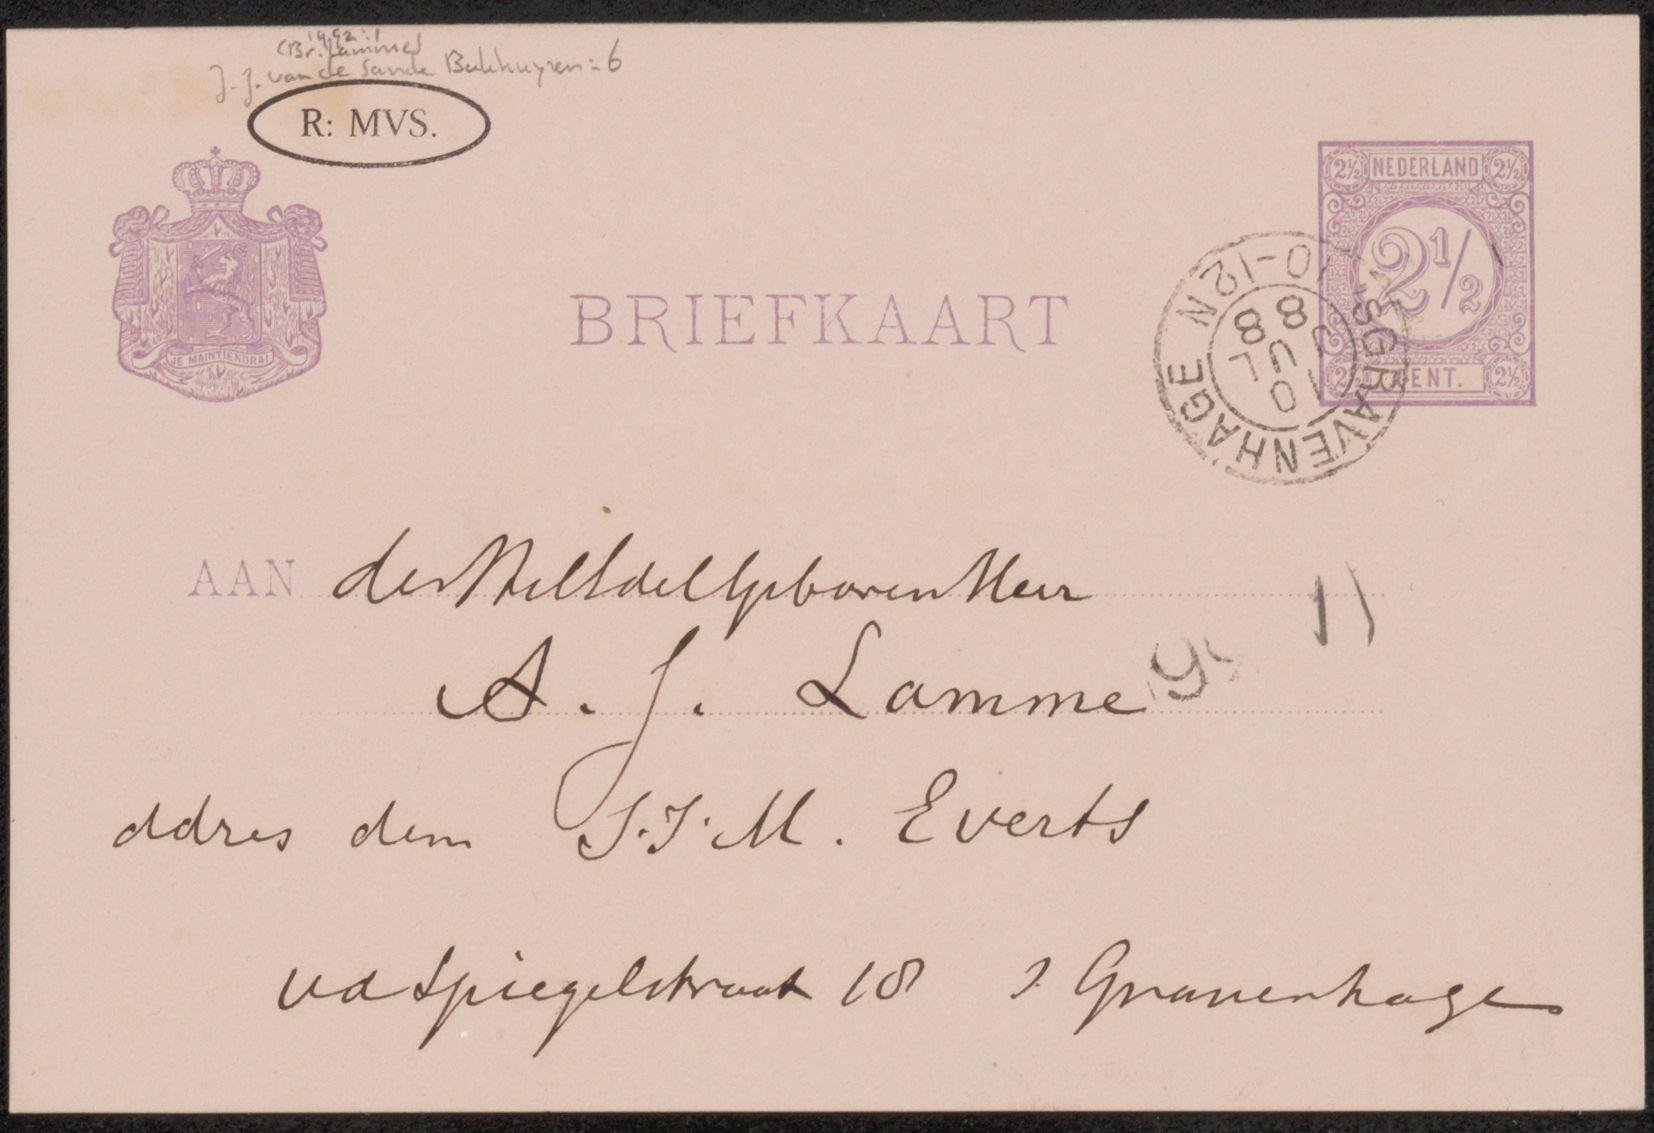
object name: postcard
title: Briefkaart aan Ary Johannes Lamme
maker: julius jacobus van de sande bakhuyzen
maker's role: draughtsman, painter, print maker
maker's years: 1835-1925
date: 1888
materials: cardboard, ink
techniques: pen, writing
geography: the hague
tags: dordrecht, ary johannes lamme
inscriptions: collector's mark: Lugt 2228